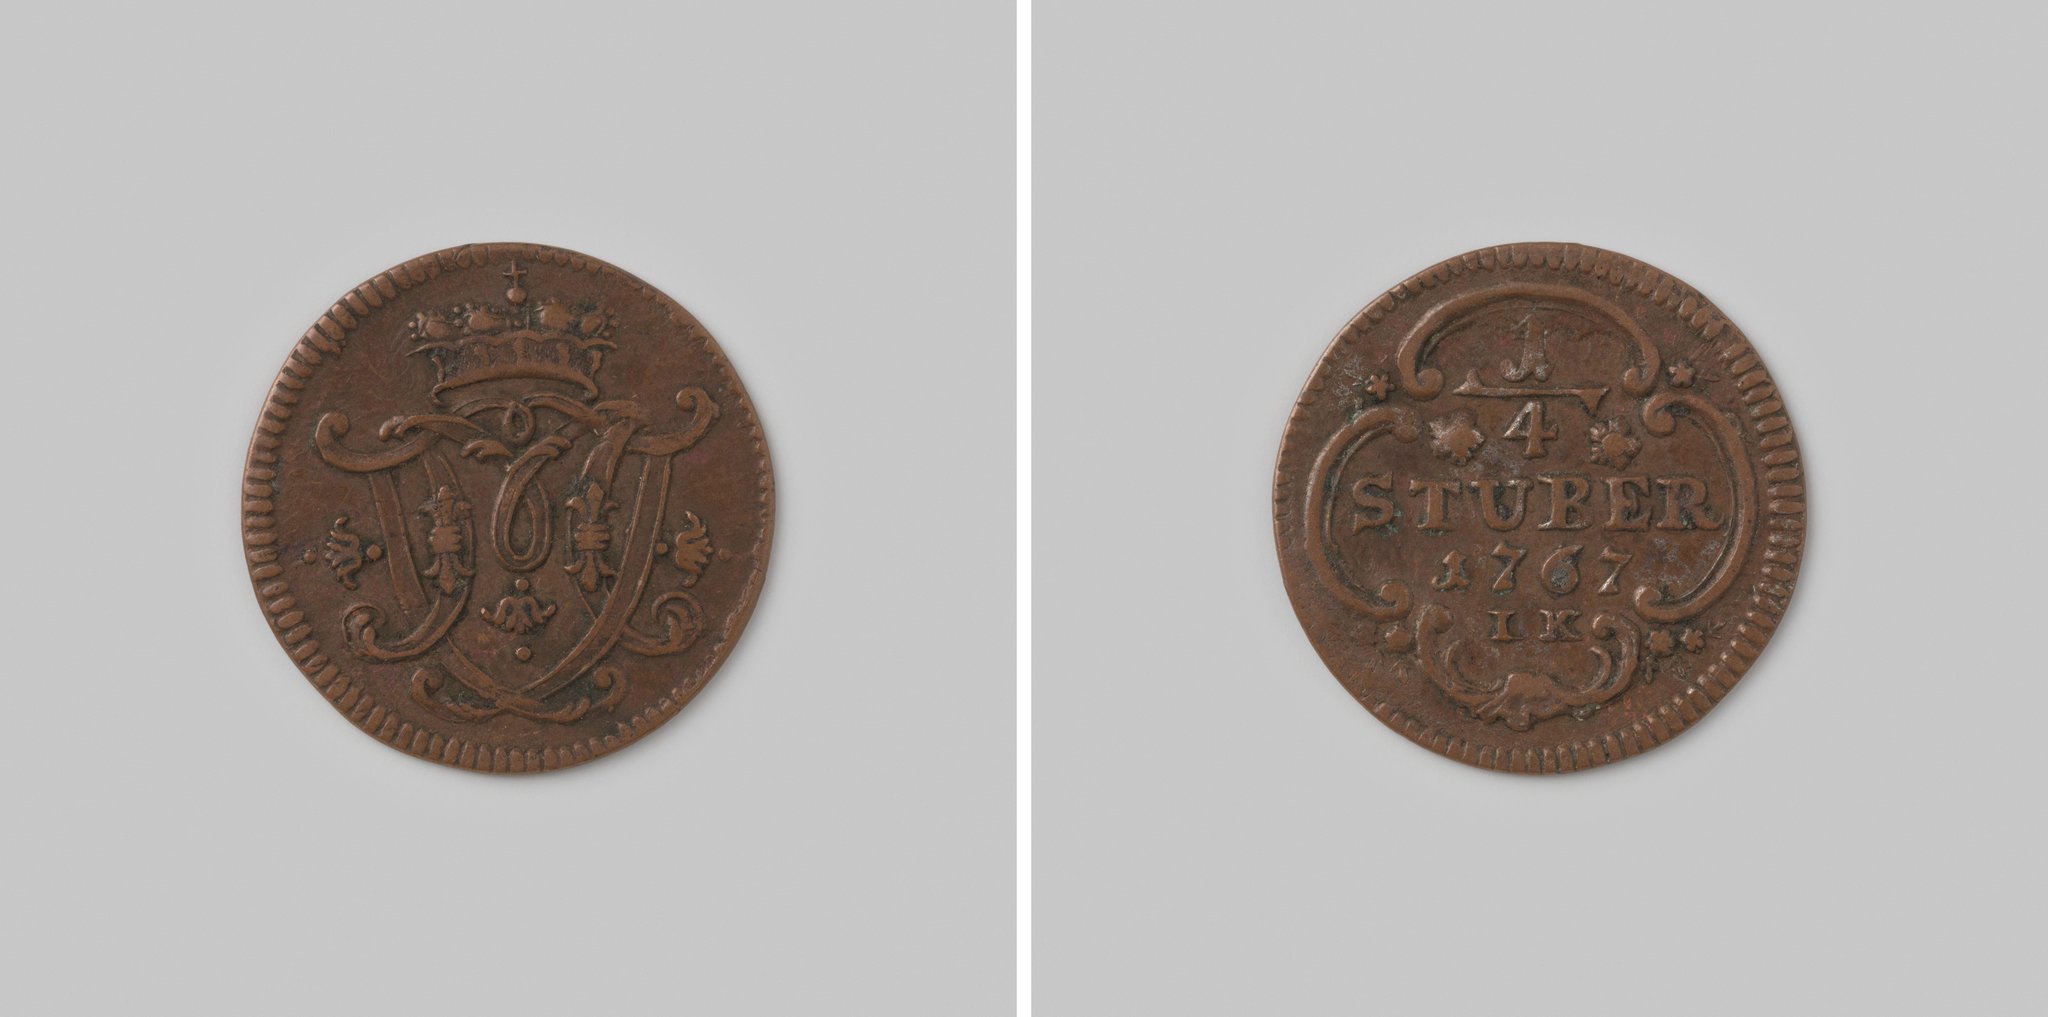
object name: coin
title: 1/4 Stüber uit het bisdom Keulen van Maximilian Friedrich, 1767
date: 1767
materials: copper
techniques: striking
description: Koperen munt. Voorzijde: gekroond versierd monogram. Keerzijde: binnen versierde vierpas waarde-aanduiding in twee regels, waaronder jaartal. Gladde rand.